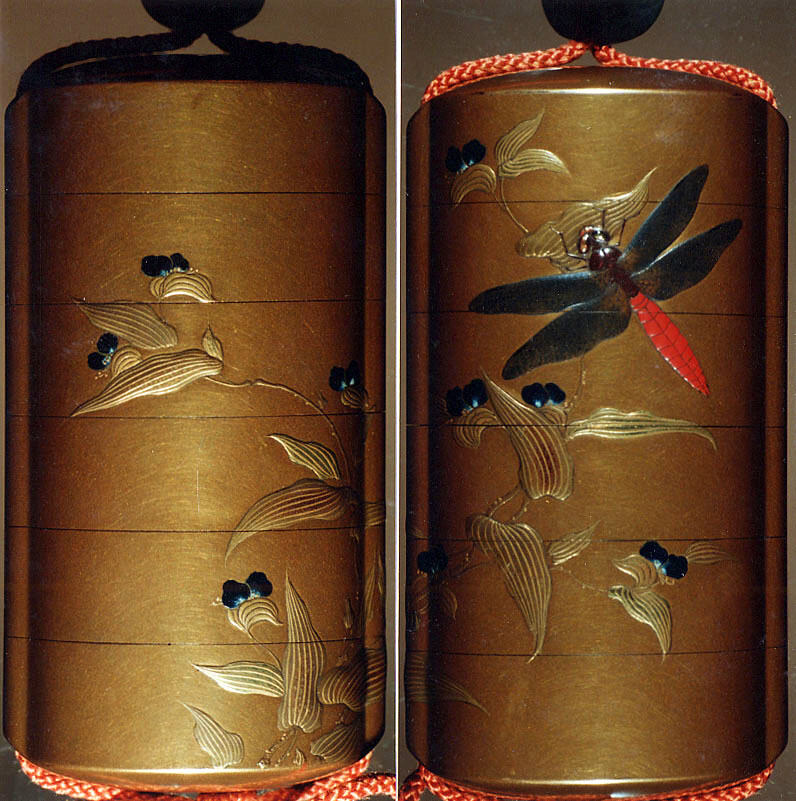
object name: inrō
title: Case (Inrō) with Design of Dragonfly Seated on Leaf of Flowering Plant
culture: japanese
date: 1801-1900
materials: gold, lacquer, silver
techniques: fundame, hiramakie, inlay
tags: dragonflies,flowers